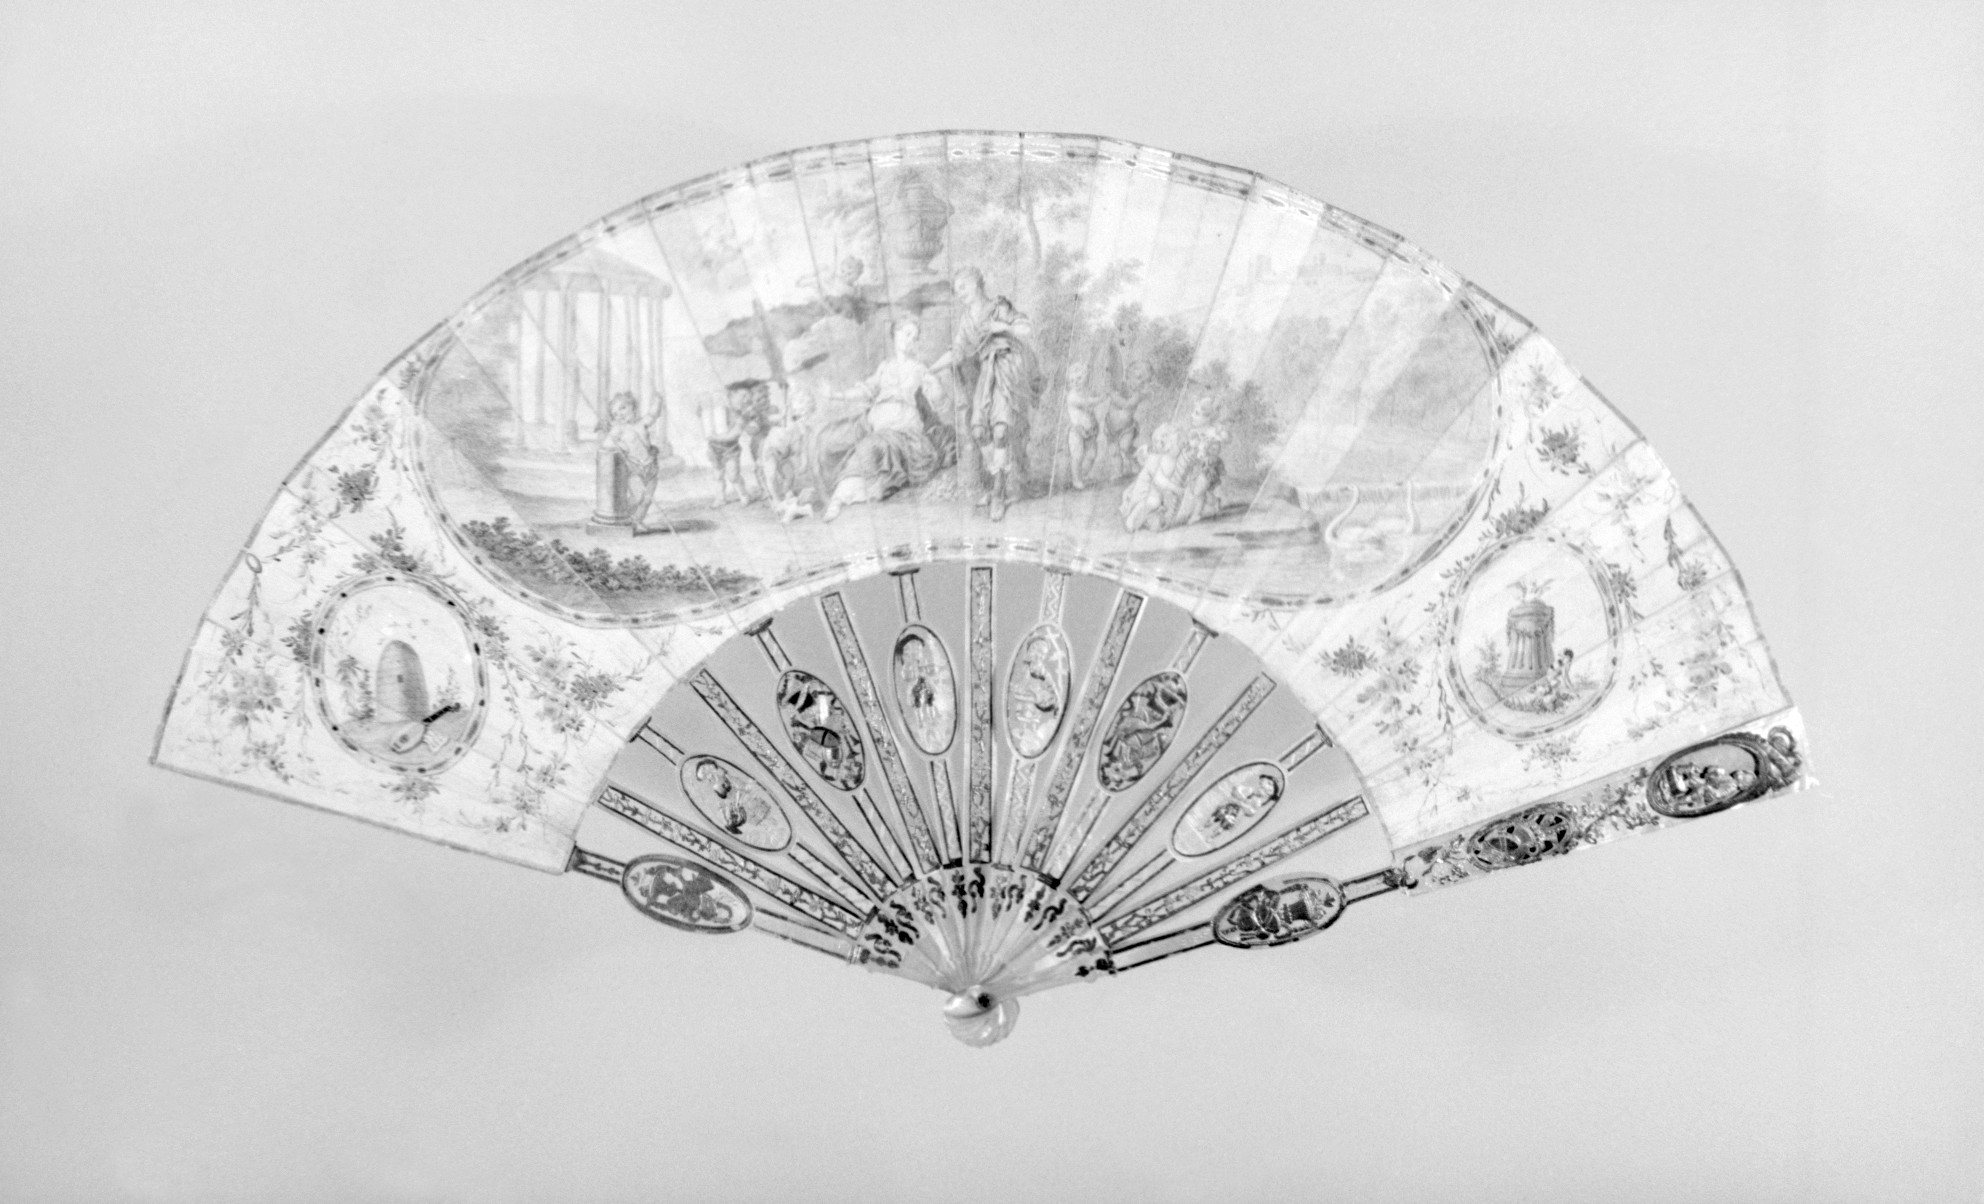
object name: fan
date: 1867-1900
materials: glass, gold, mother of pearl, paint, paper, silver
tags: children,women,lutes,swans